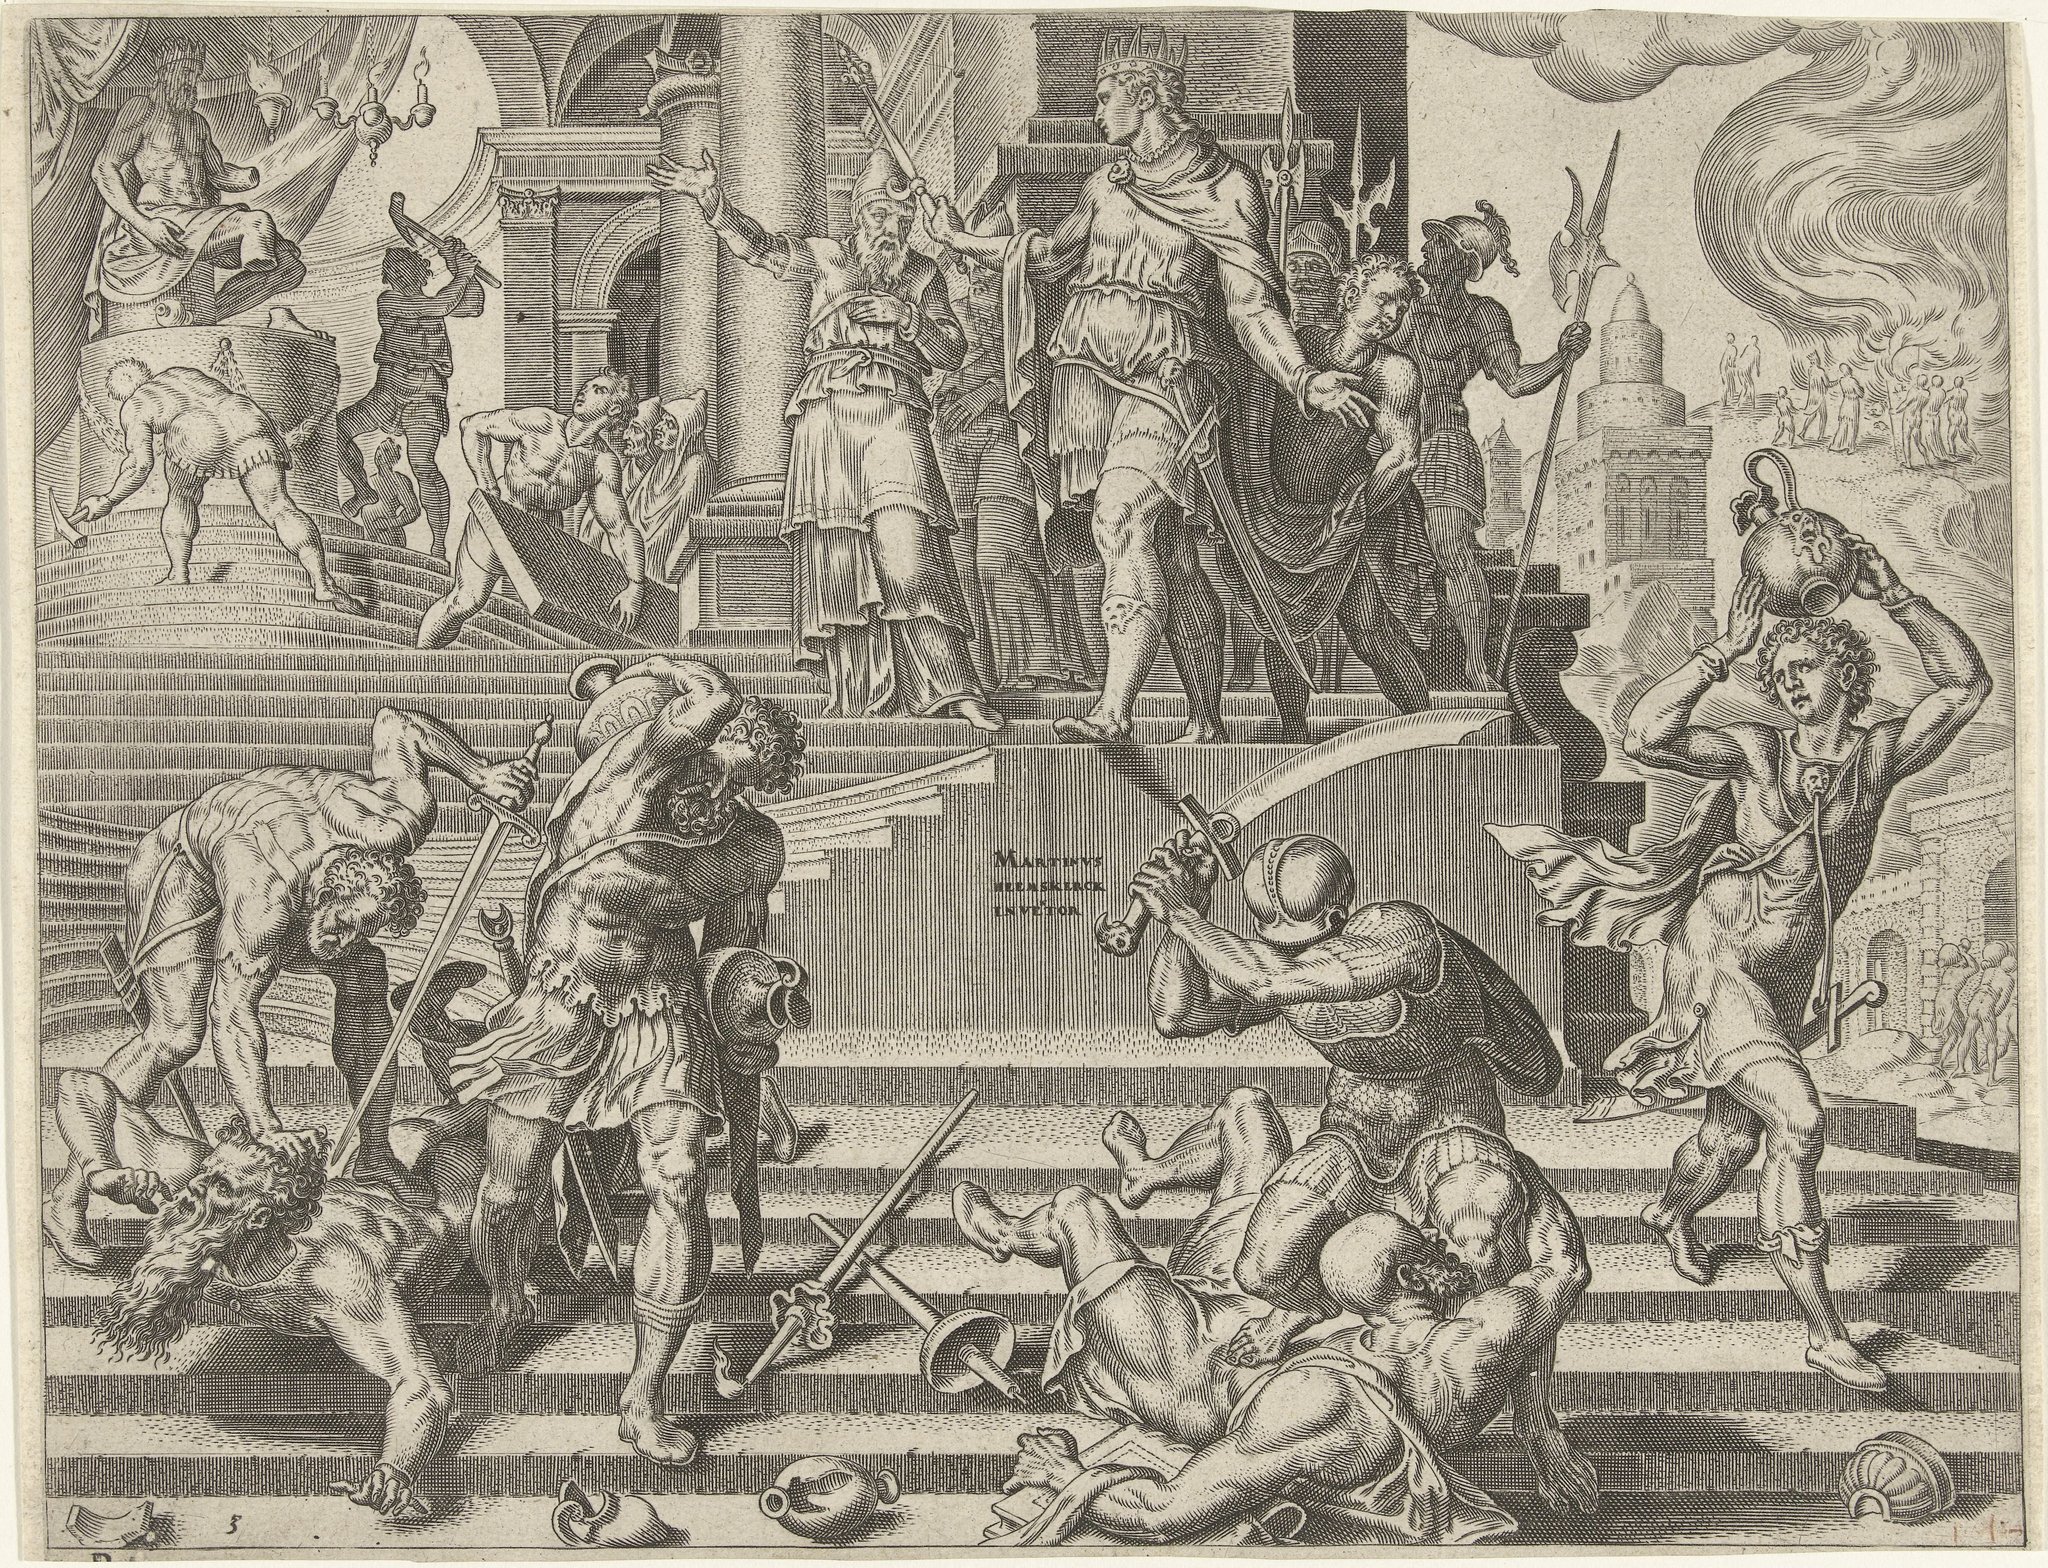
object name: print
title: Geschiedenis van koning Josia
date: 1569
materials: paper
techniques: engraving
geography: haarlem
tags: all the idols are brought out of the temple, burned, and their ashes pounded to dust ~ story of josiah, the pagan priests are either killed or suppressed ~ story of josiah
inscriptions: collector's mark: Lugt 2228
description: Koning Josia geeft opdracht om de tempel van Baäl te verwoesten en de Baälpriesters te vermoorden. Alle voorwerpen die ter ere van de afgod zijn gemaakt worden van Josia's soldaten buiten de stad verbrand. Rechtsachter is het vuur te zien.